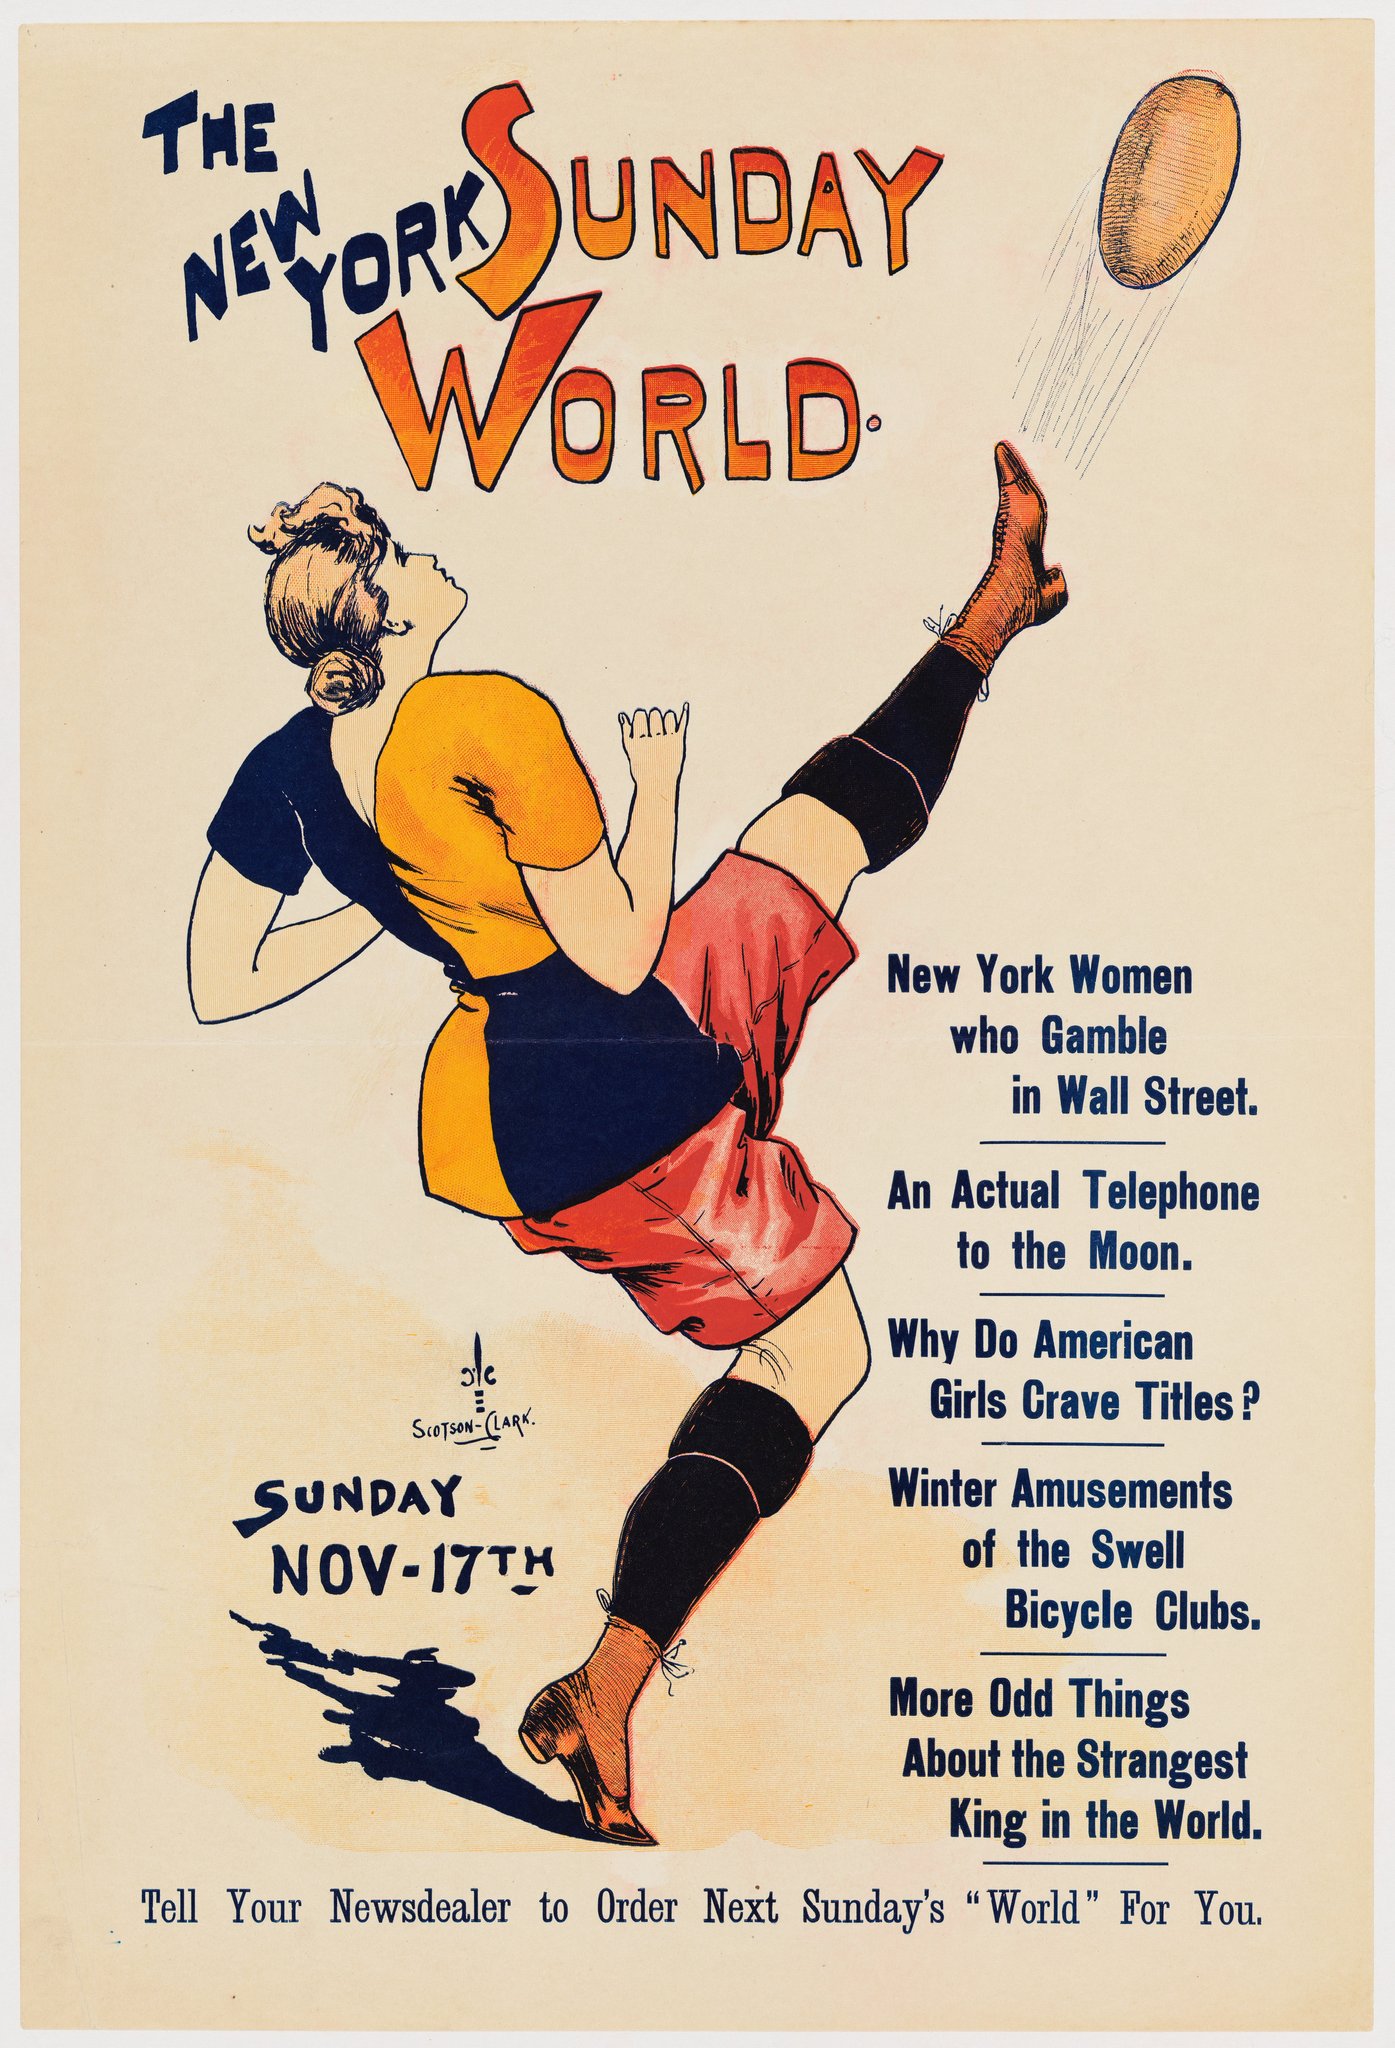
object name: poster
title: The New York Sunday World, November 17th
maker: george frederick scotson-clark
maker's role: artist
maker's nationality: american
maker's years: 1873-1973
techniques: lithograph